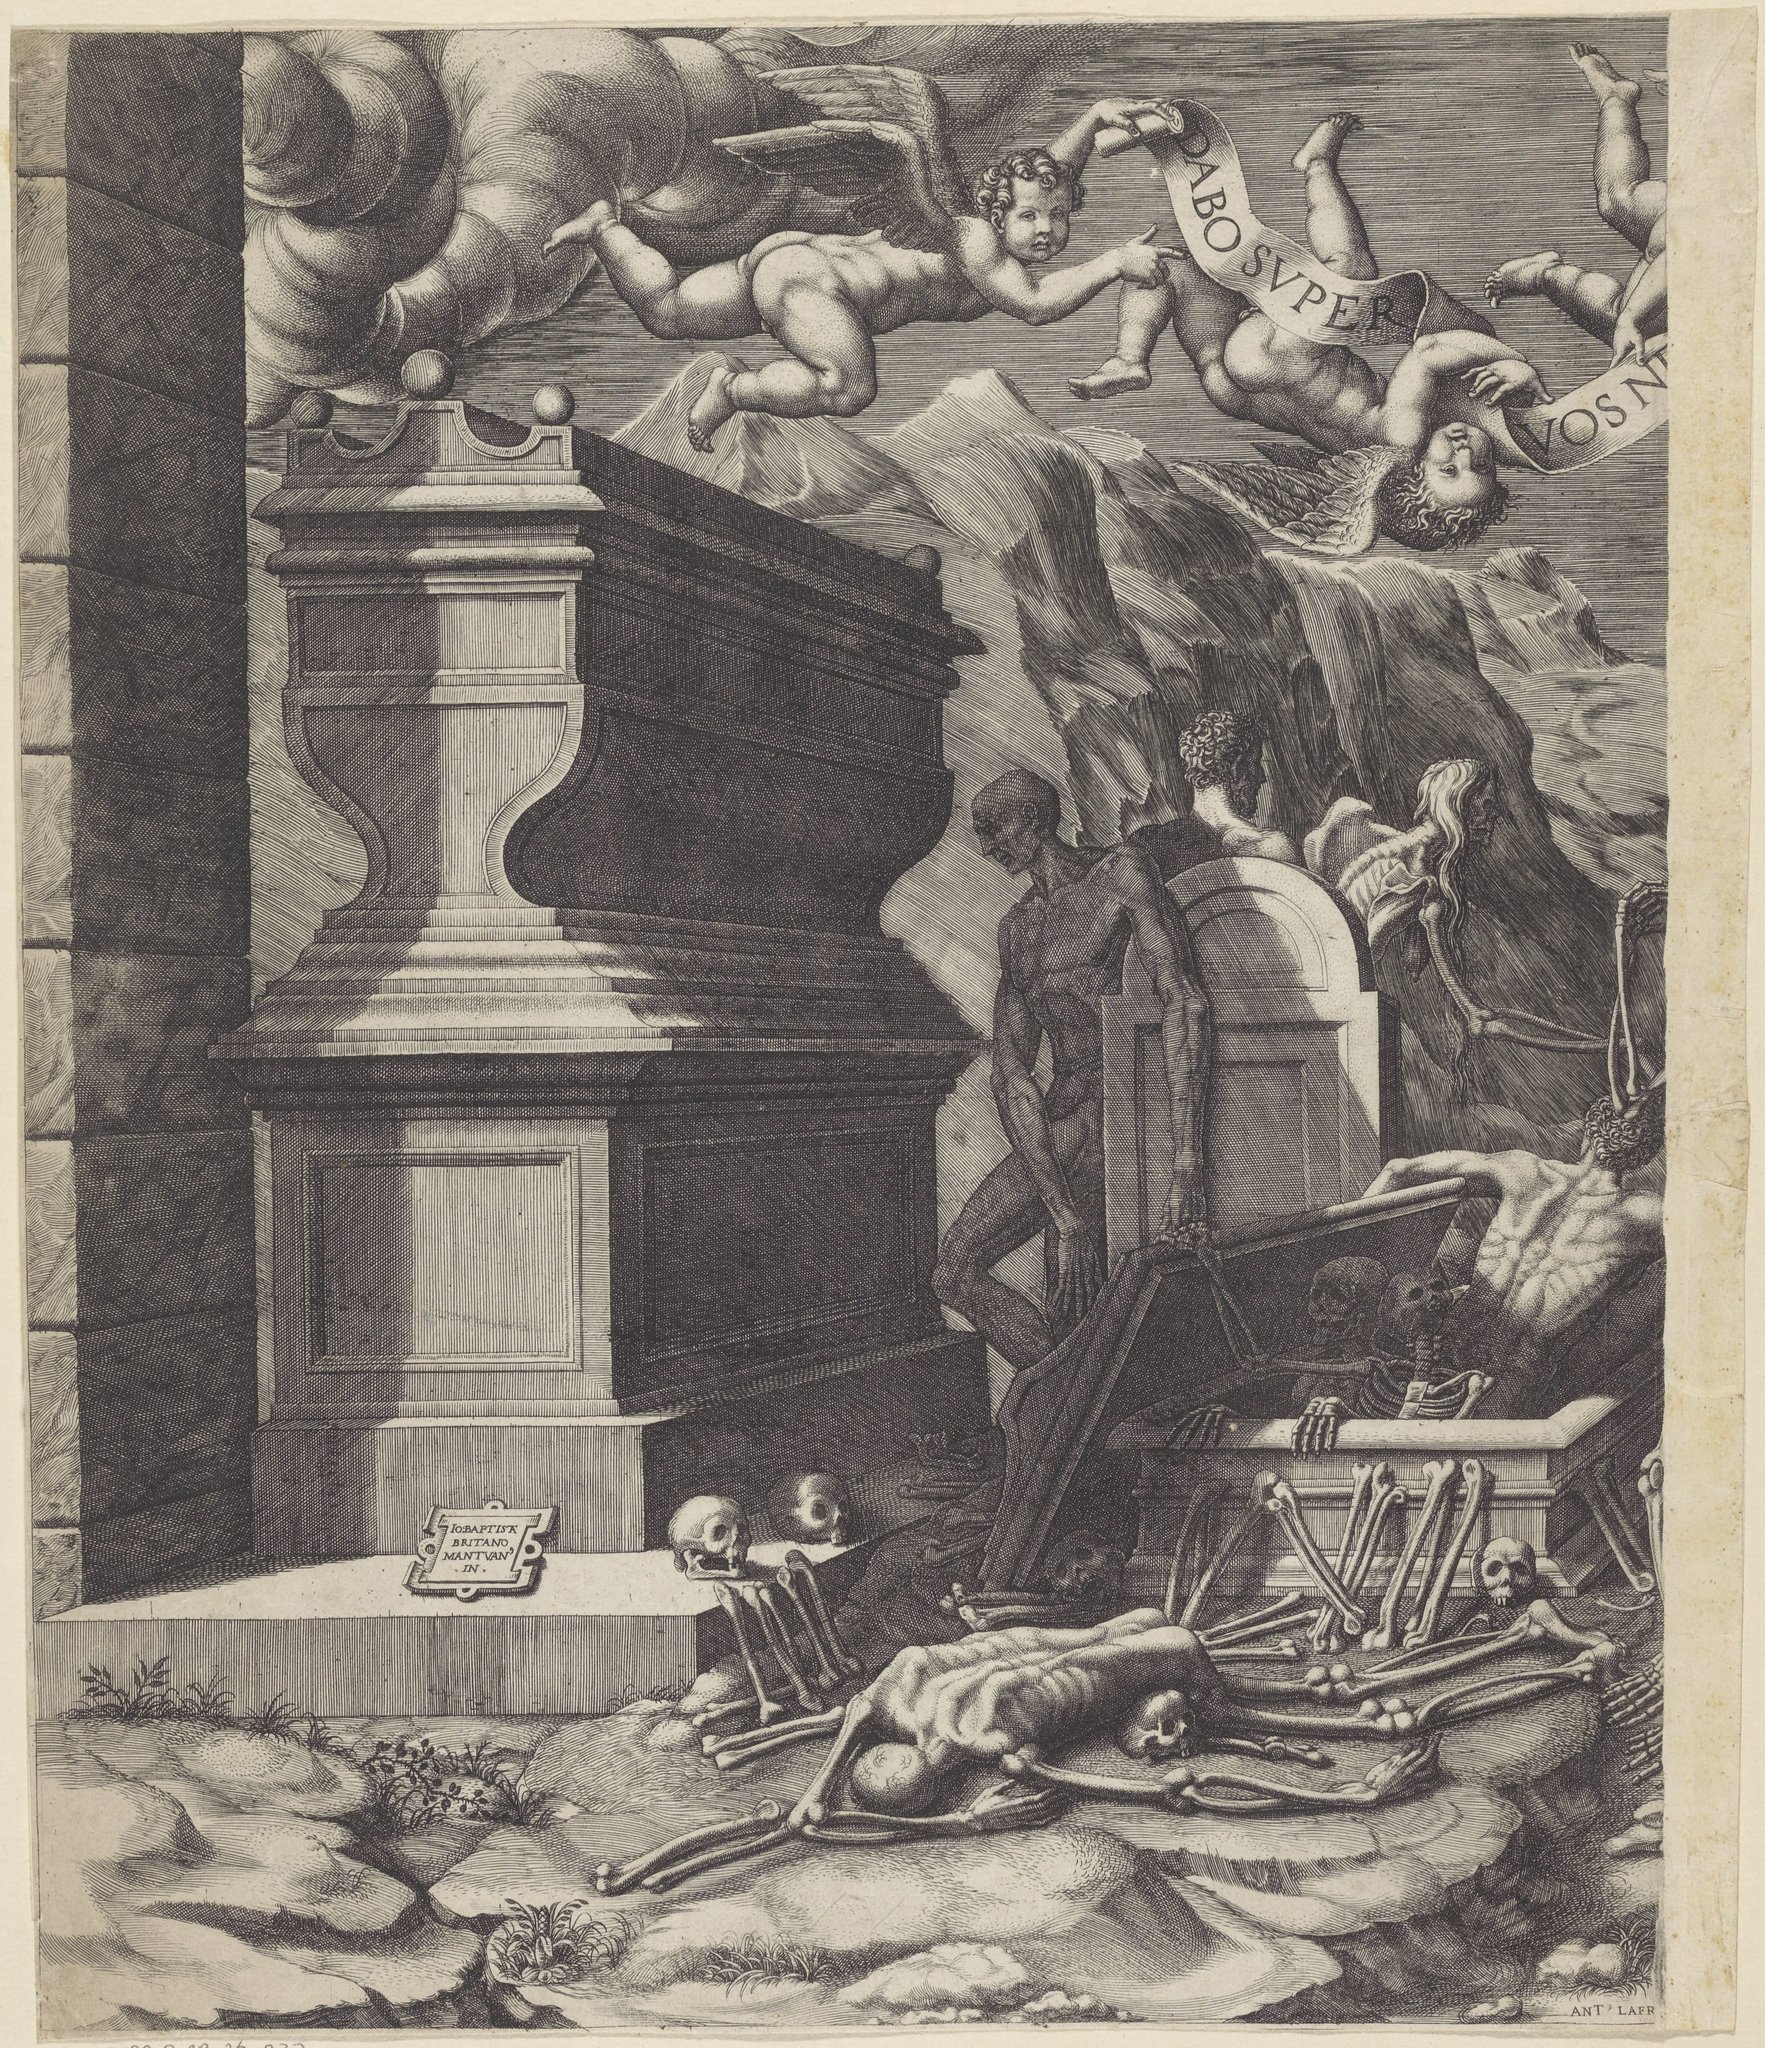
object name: print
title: Visioen van Ezechiël over het dal van beenderen, linkerhelft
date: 1530-1582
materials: paper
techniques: engraving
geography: italy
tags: ezekiel's vision of the valley of the dry bones (ezekiel 37:1-10)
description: De profeet Ezechiël heeft een visioen van het dal vol dorre beenderen die met vlees worden bekleed en tot leven komen. Verschillende sarcofagen en grafzerken verspreid door de voorstelling. Boven zweven vijf putti die samen een baderon vasthouden met de tekst: Dabo super vos ner vos et succrescere facia sup vos carne.